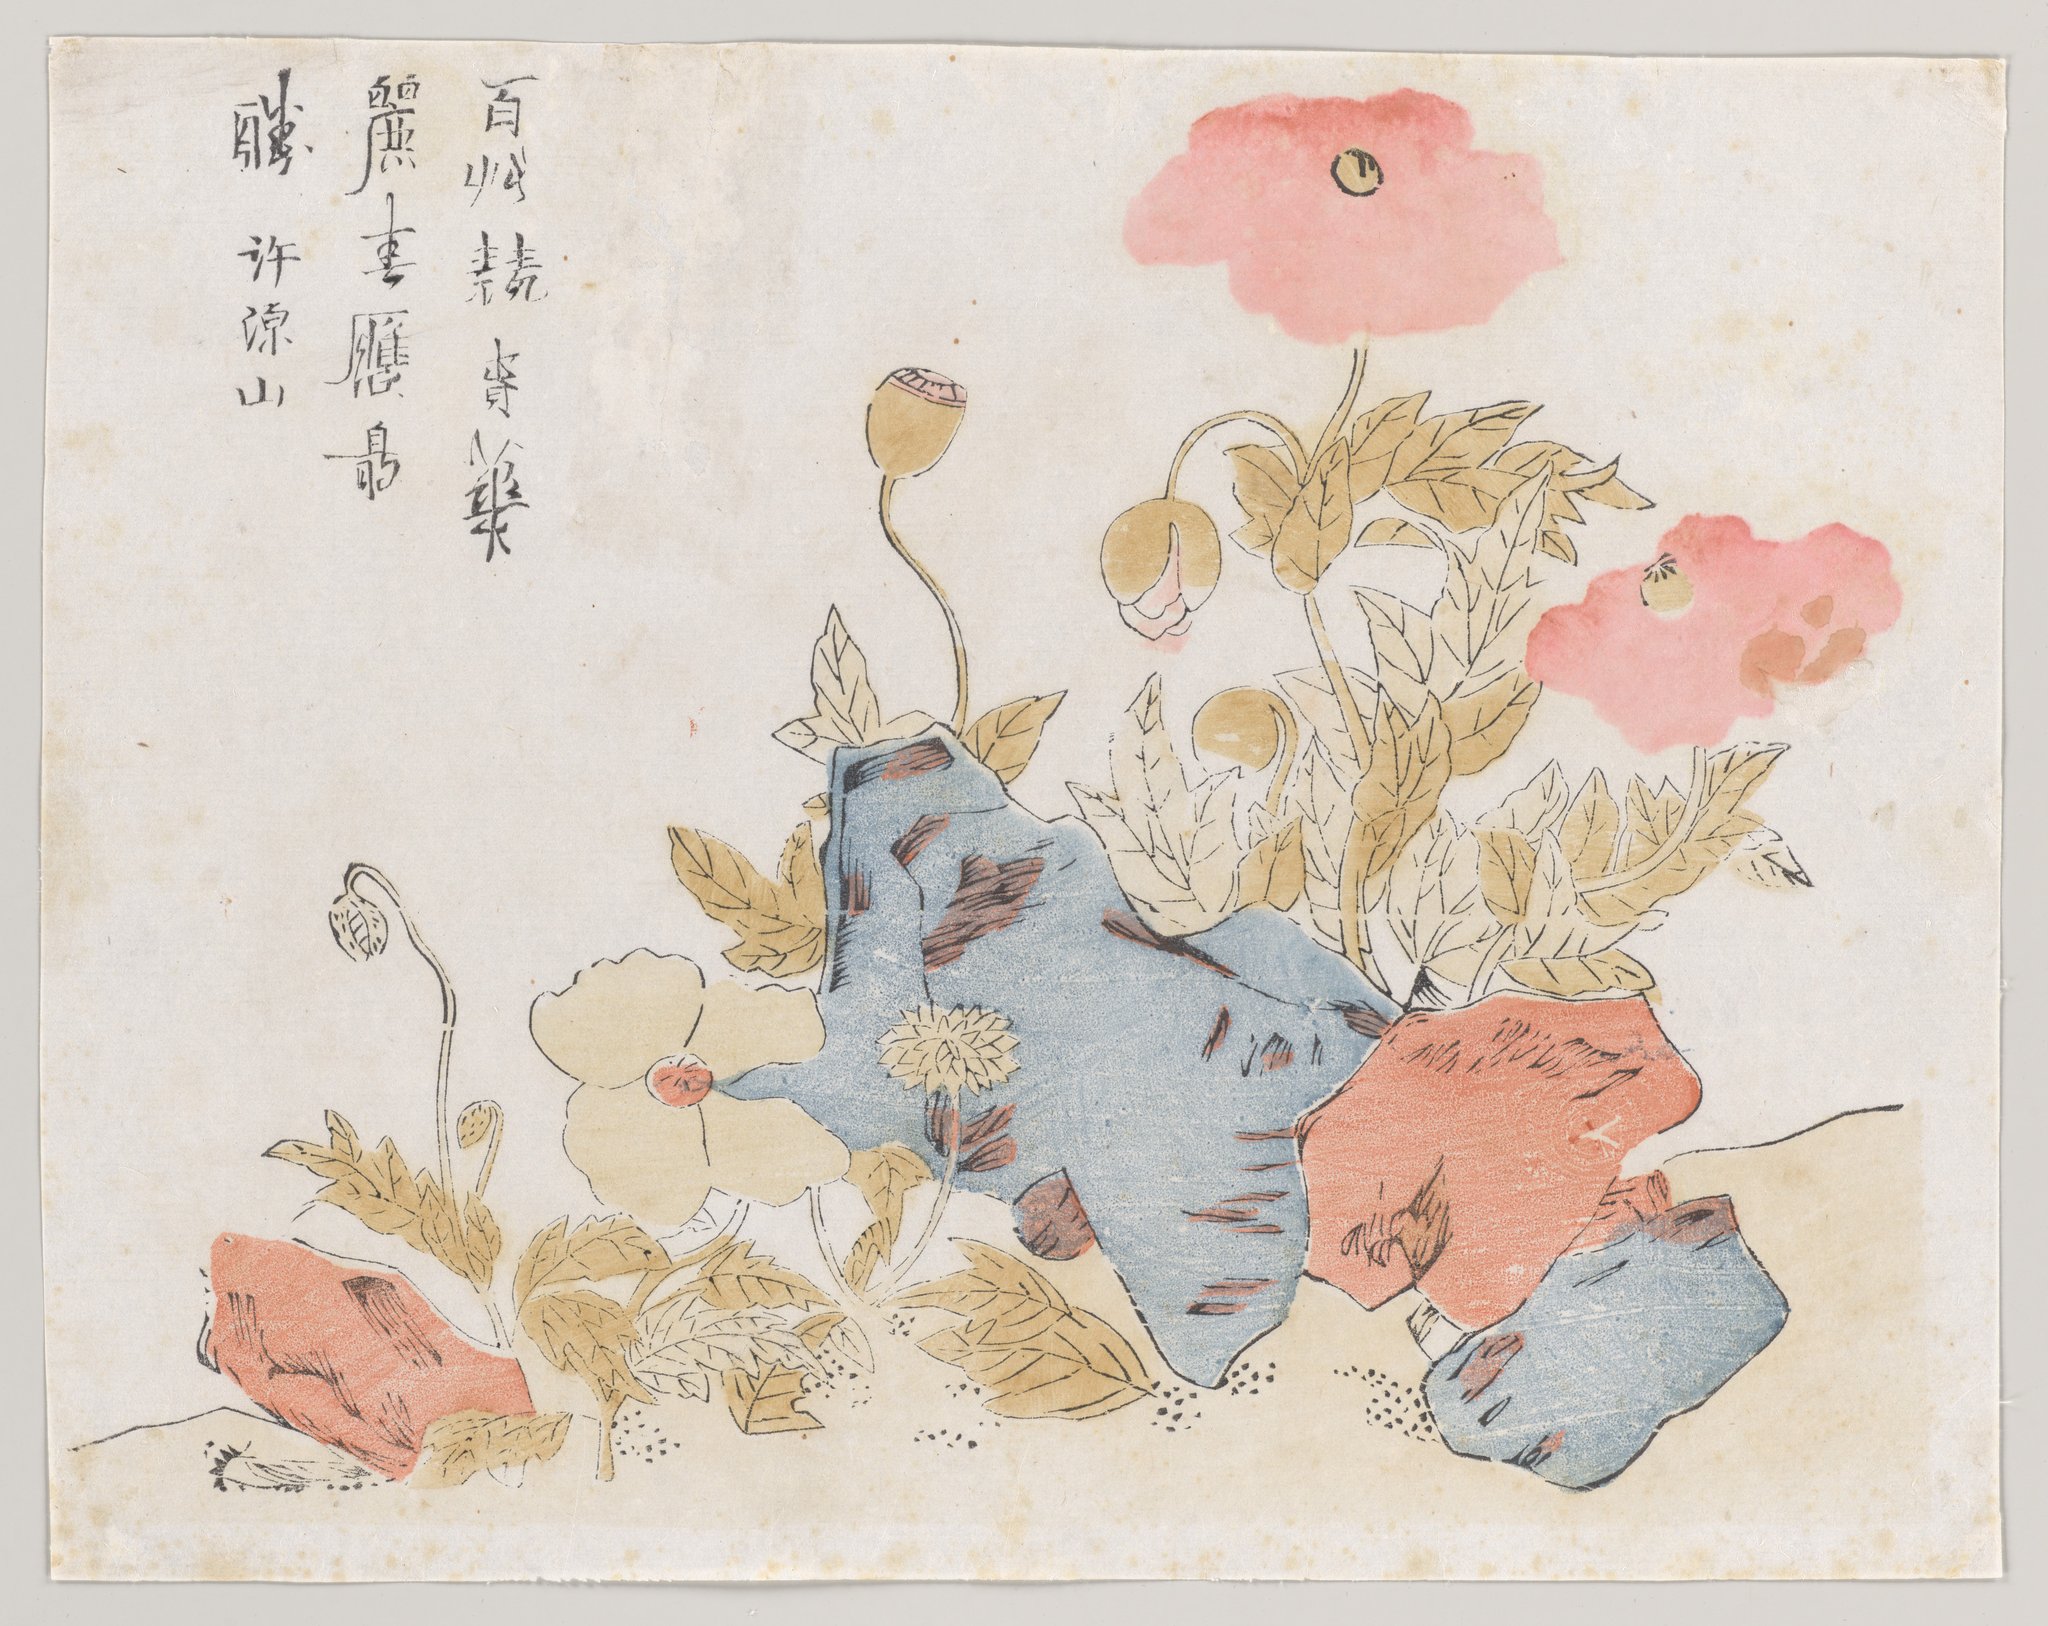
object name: print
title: Poppy and Stone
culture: chinese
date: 1701-1800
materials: ink, paper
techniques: polychrome, woodblock print